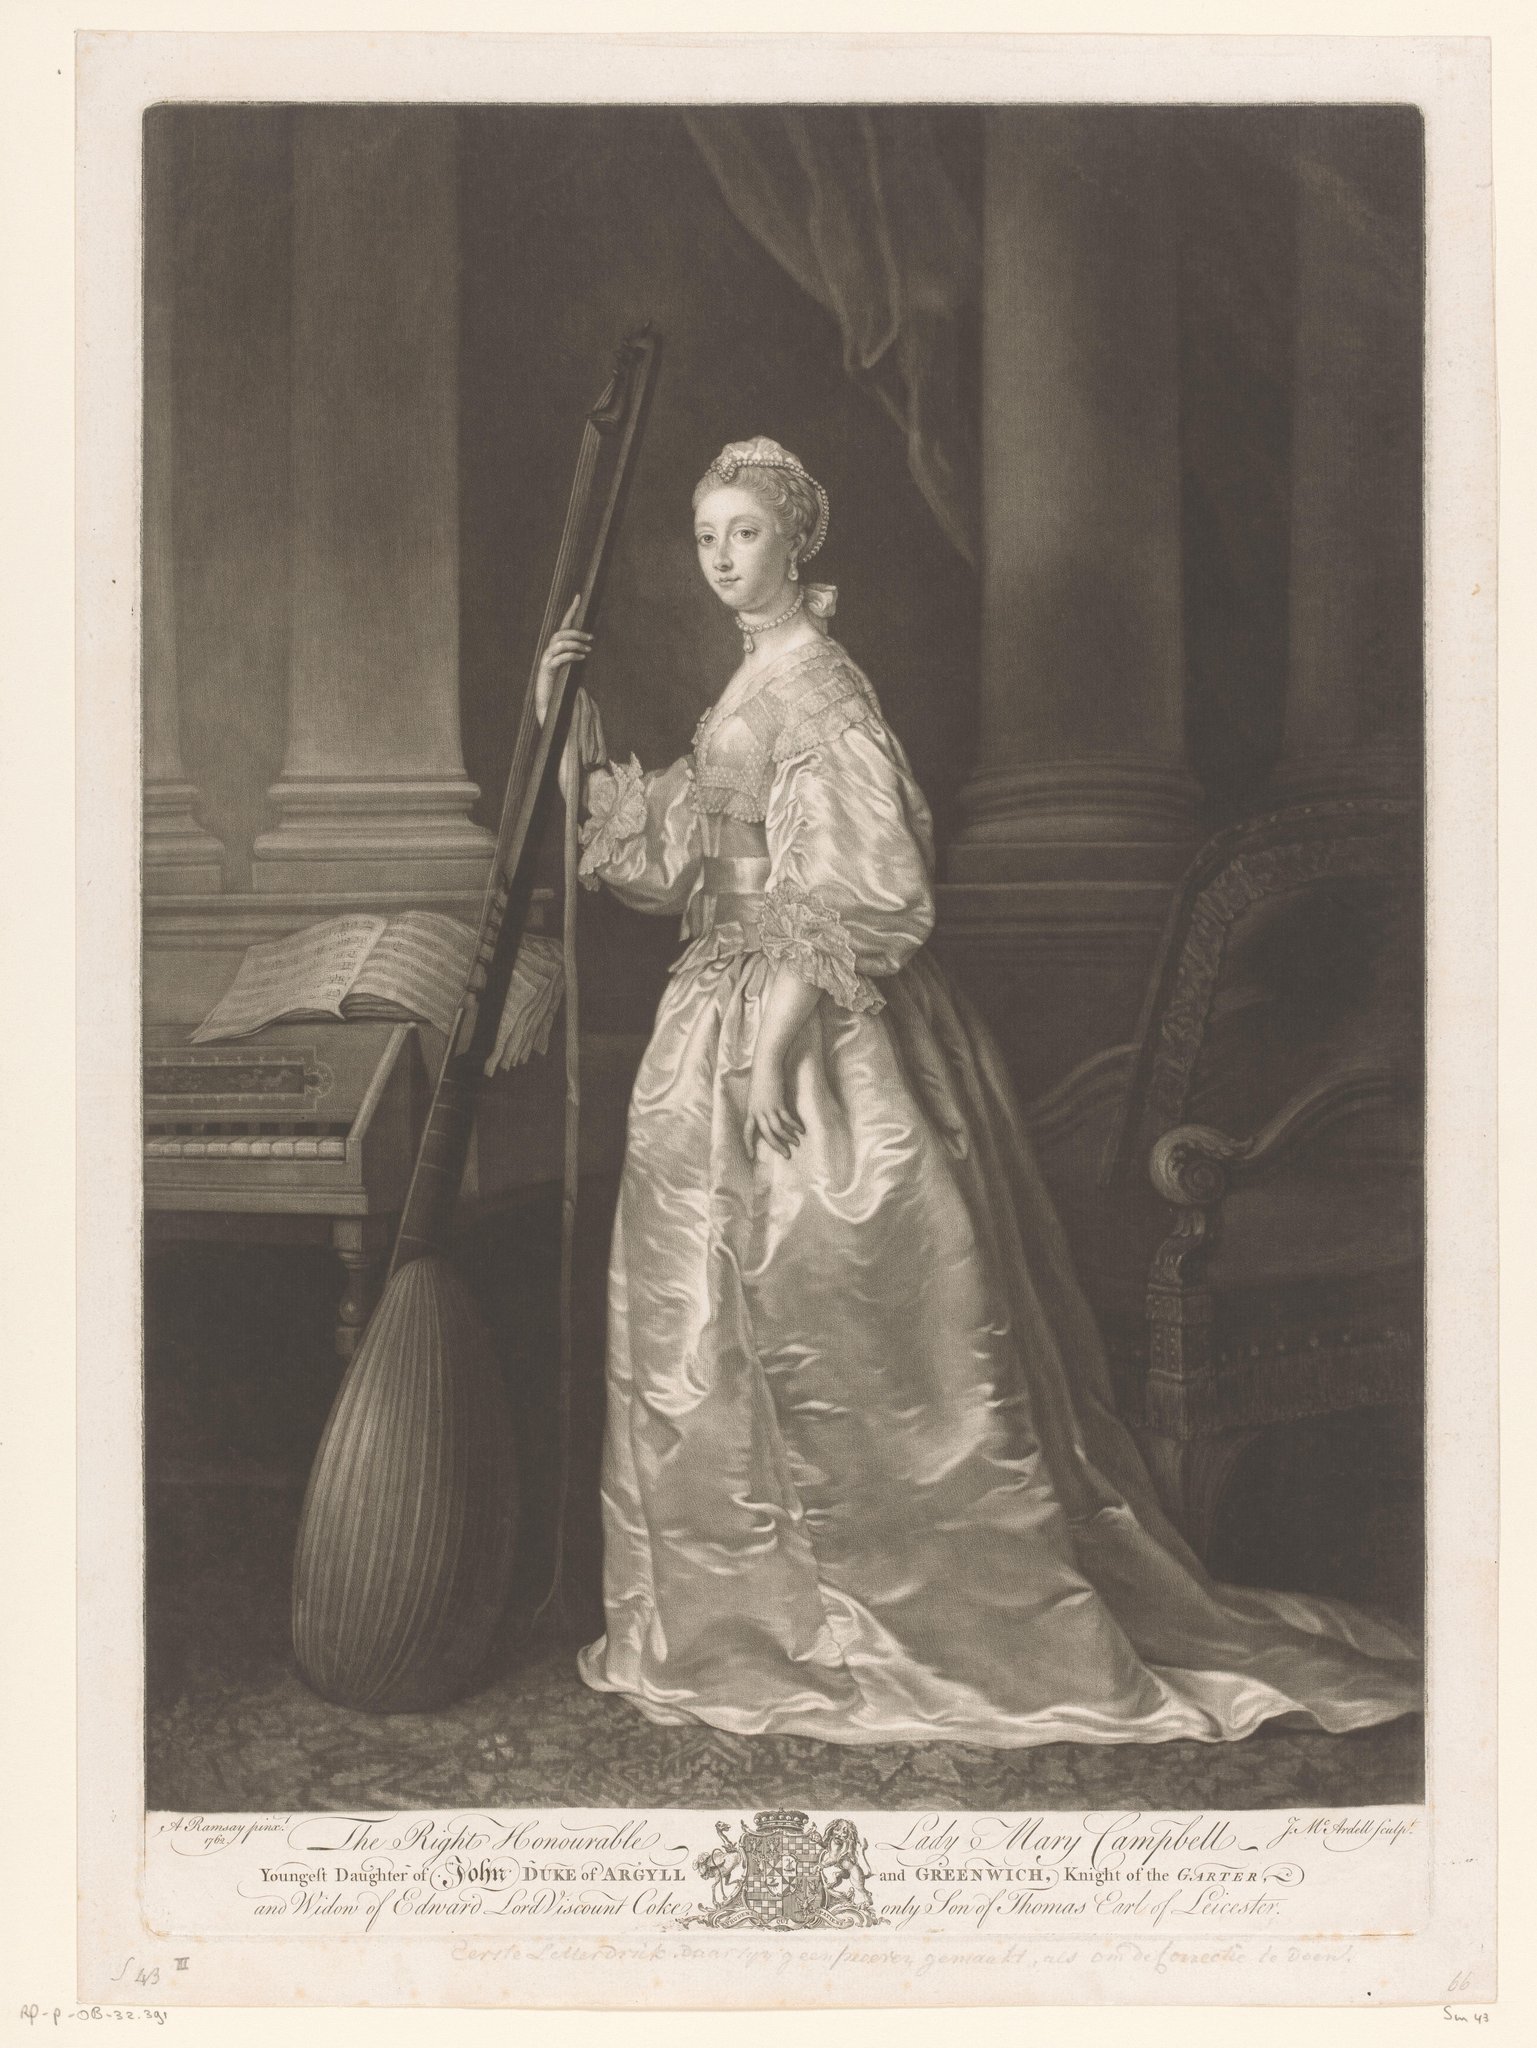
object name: print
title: The Right Honourable Lady Mary Campbell (...)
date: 1762-1764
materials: paper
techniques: mezzotint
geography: london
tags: historical persons - bb - woman, lute, and special forms of lute, e.g.: theorbo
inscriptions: collector's mark: Lugt 240, inscription: ‘Eerste letterdruk. Daar zijn geen proeven gemaakt, als om de correctie te doen.’